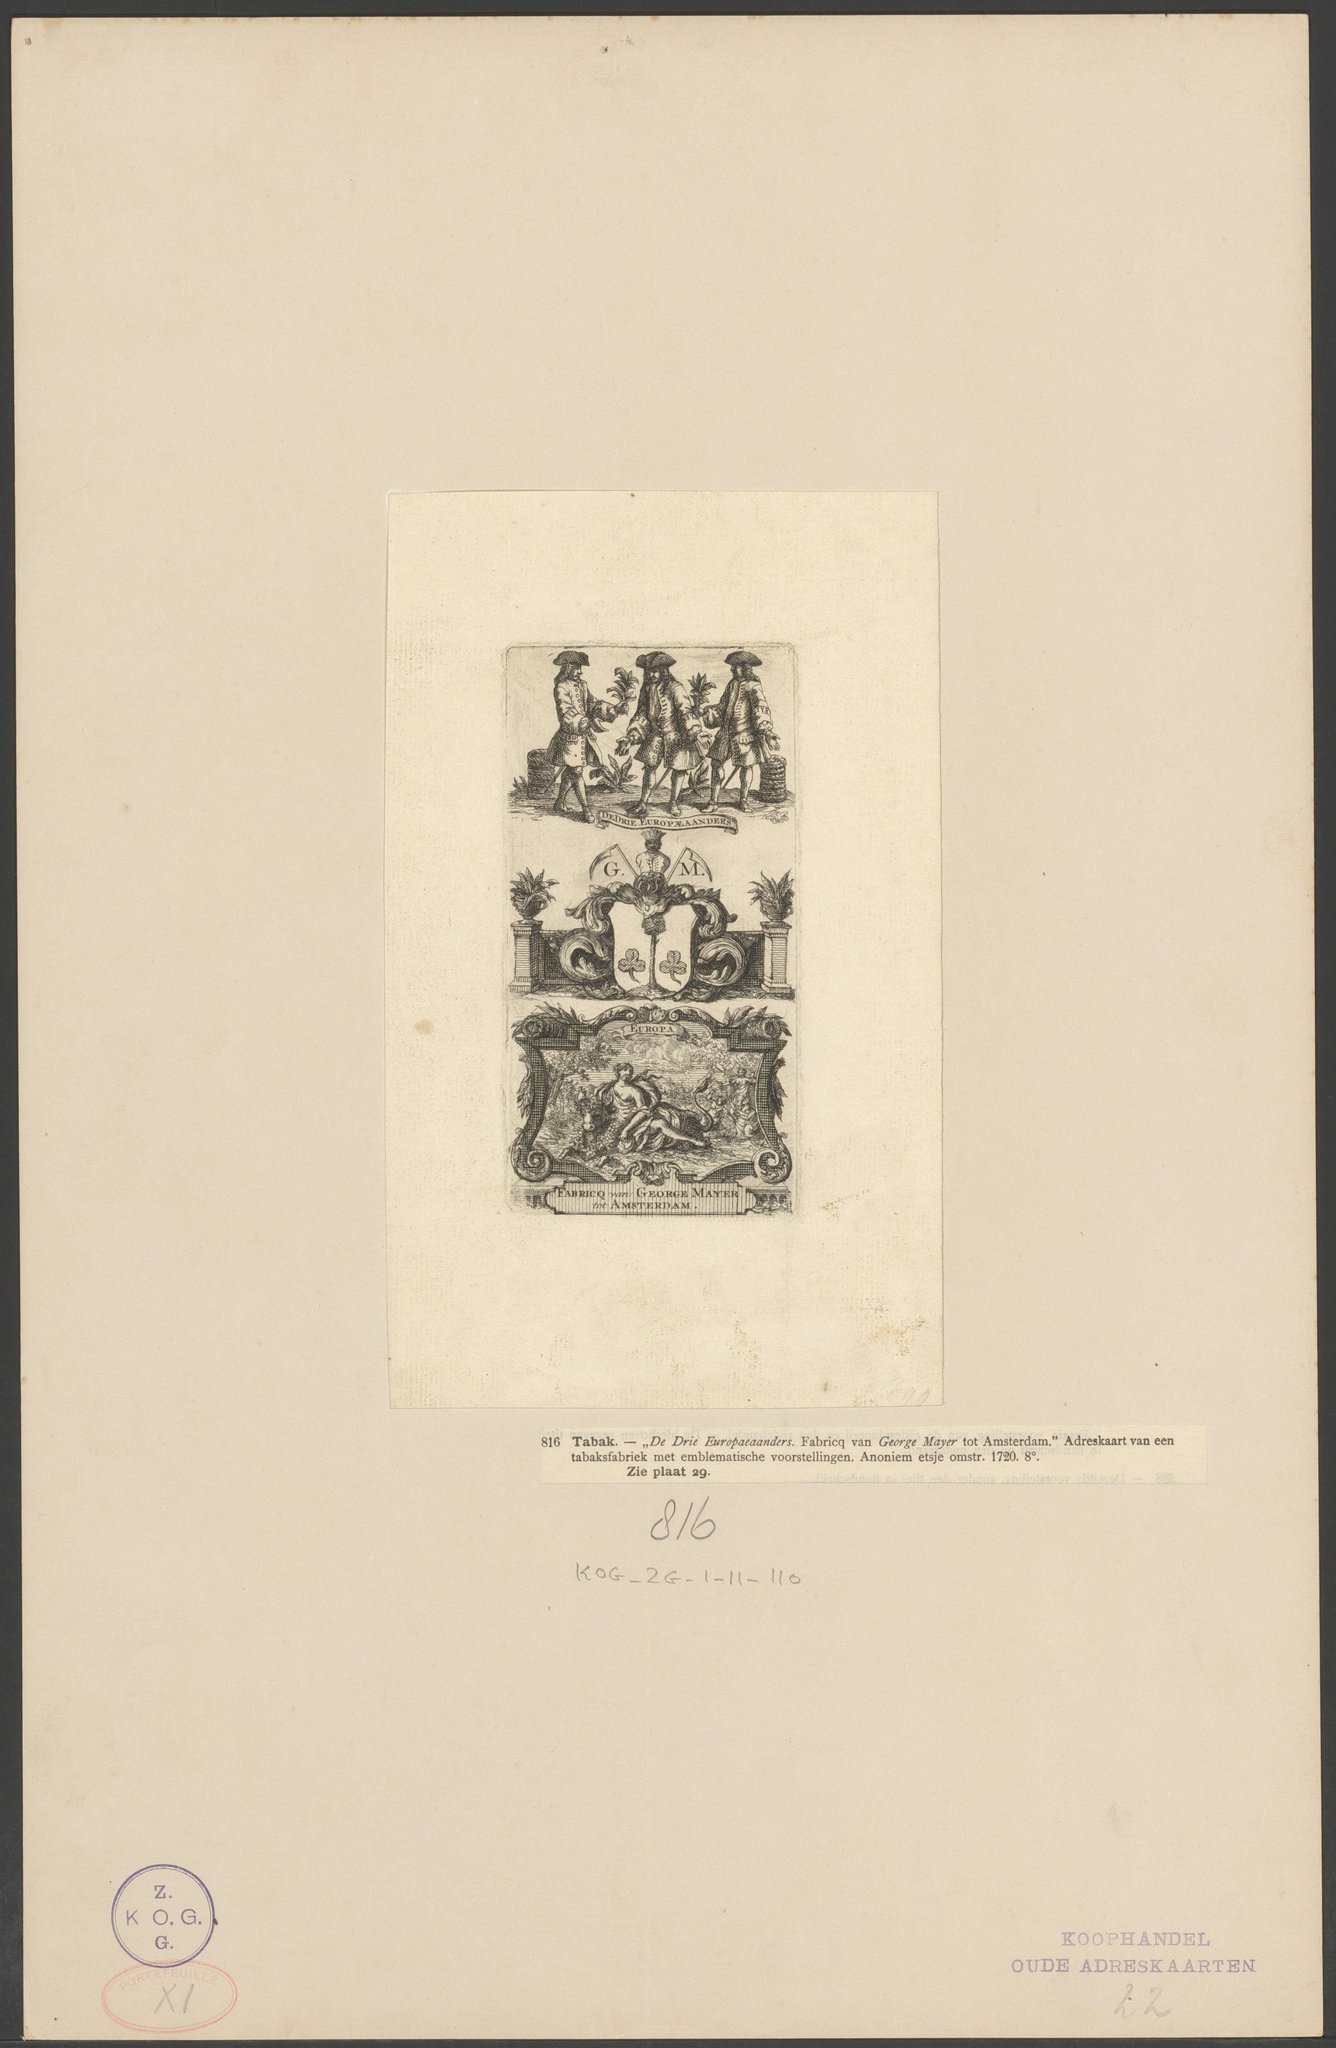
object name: print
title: De Drie Europeaeaanders / Fabricq van George Mayer tot Amsterdam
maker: Anonymous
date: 1700-1749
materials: paper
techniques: engraving, etching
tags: jupiter, usually in the shape of a white bull, abducts europa and carries her across the water, tobacco, white races and peoples, armorial bearing, heraldry, amsterdam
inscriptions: stamp, collector's mark: Lugt 1641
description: Handelsetiket van de Drie Europaeaanders. Bovenaan de drie Europese mannen met tabaksplanten in hun handen. In het midden een wapenschild. Onderaan de ontvoering van Europa. Onderwerpsrubrieken binnen de Atlas Zeden en Gewoonten: Handel, nijverheid en verkeer, Koophandel, Veilingen, Makelaardij en Verzekeringswezen, Oude adreskaarten van winkels en fabrieken, reclame.